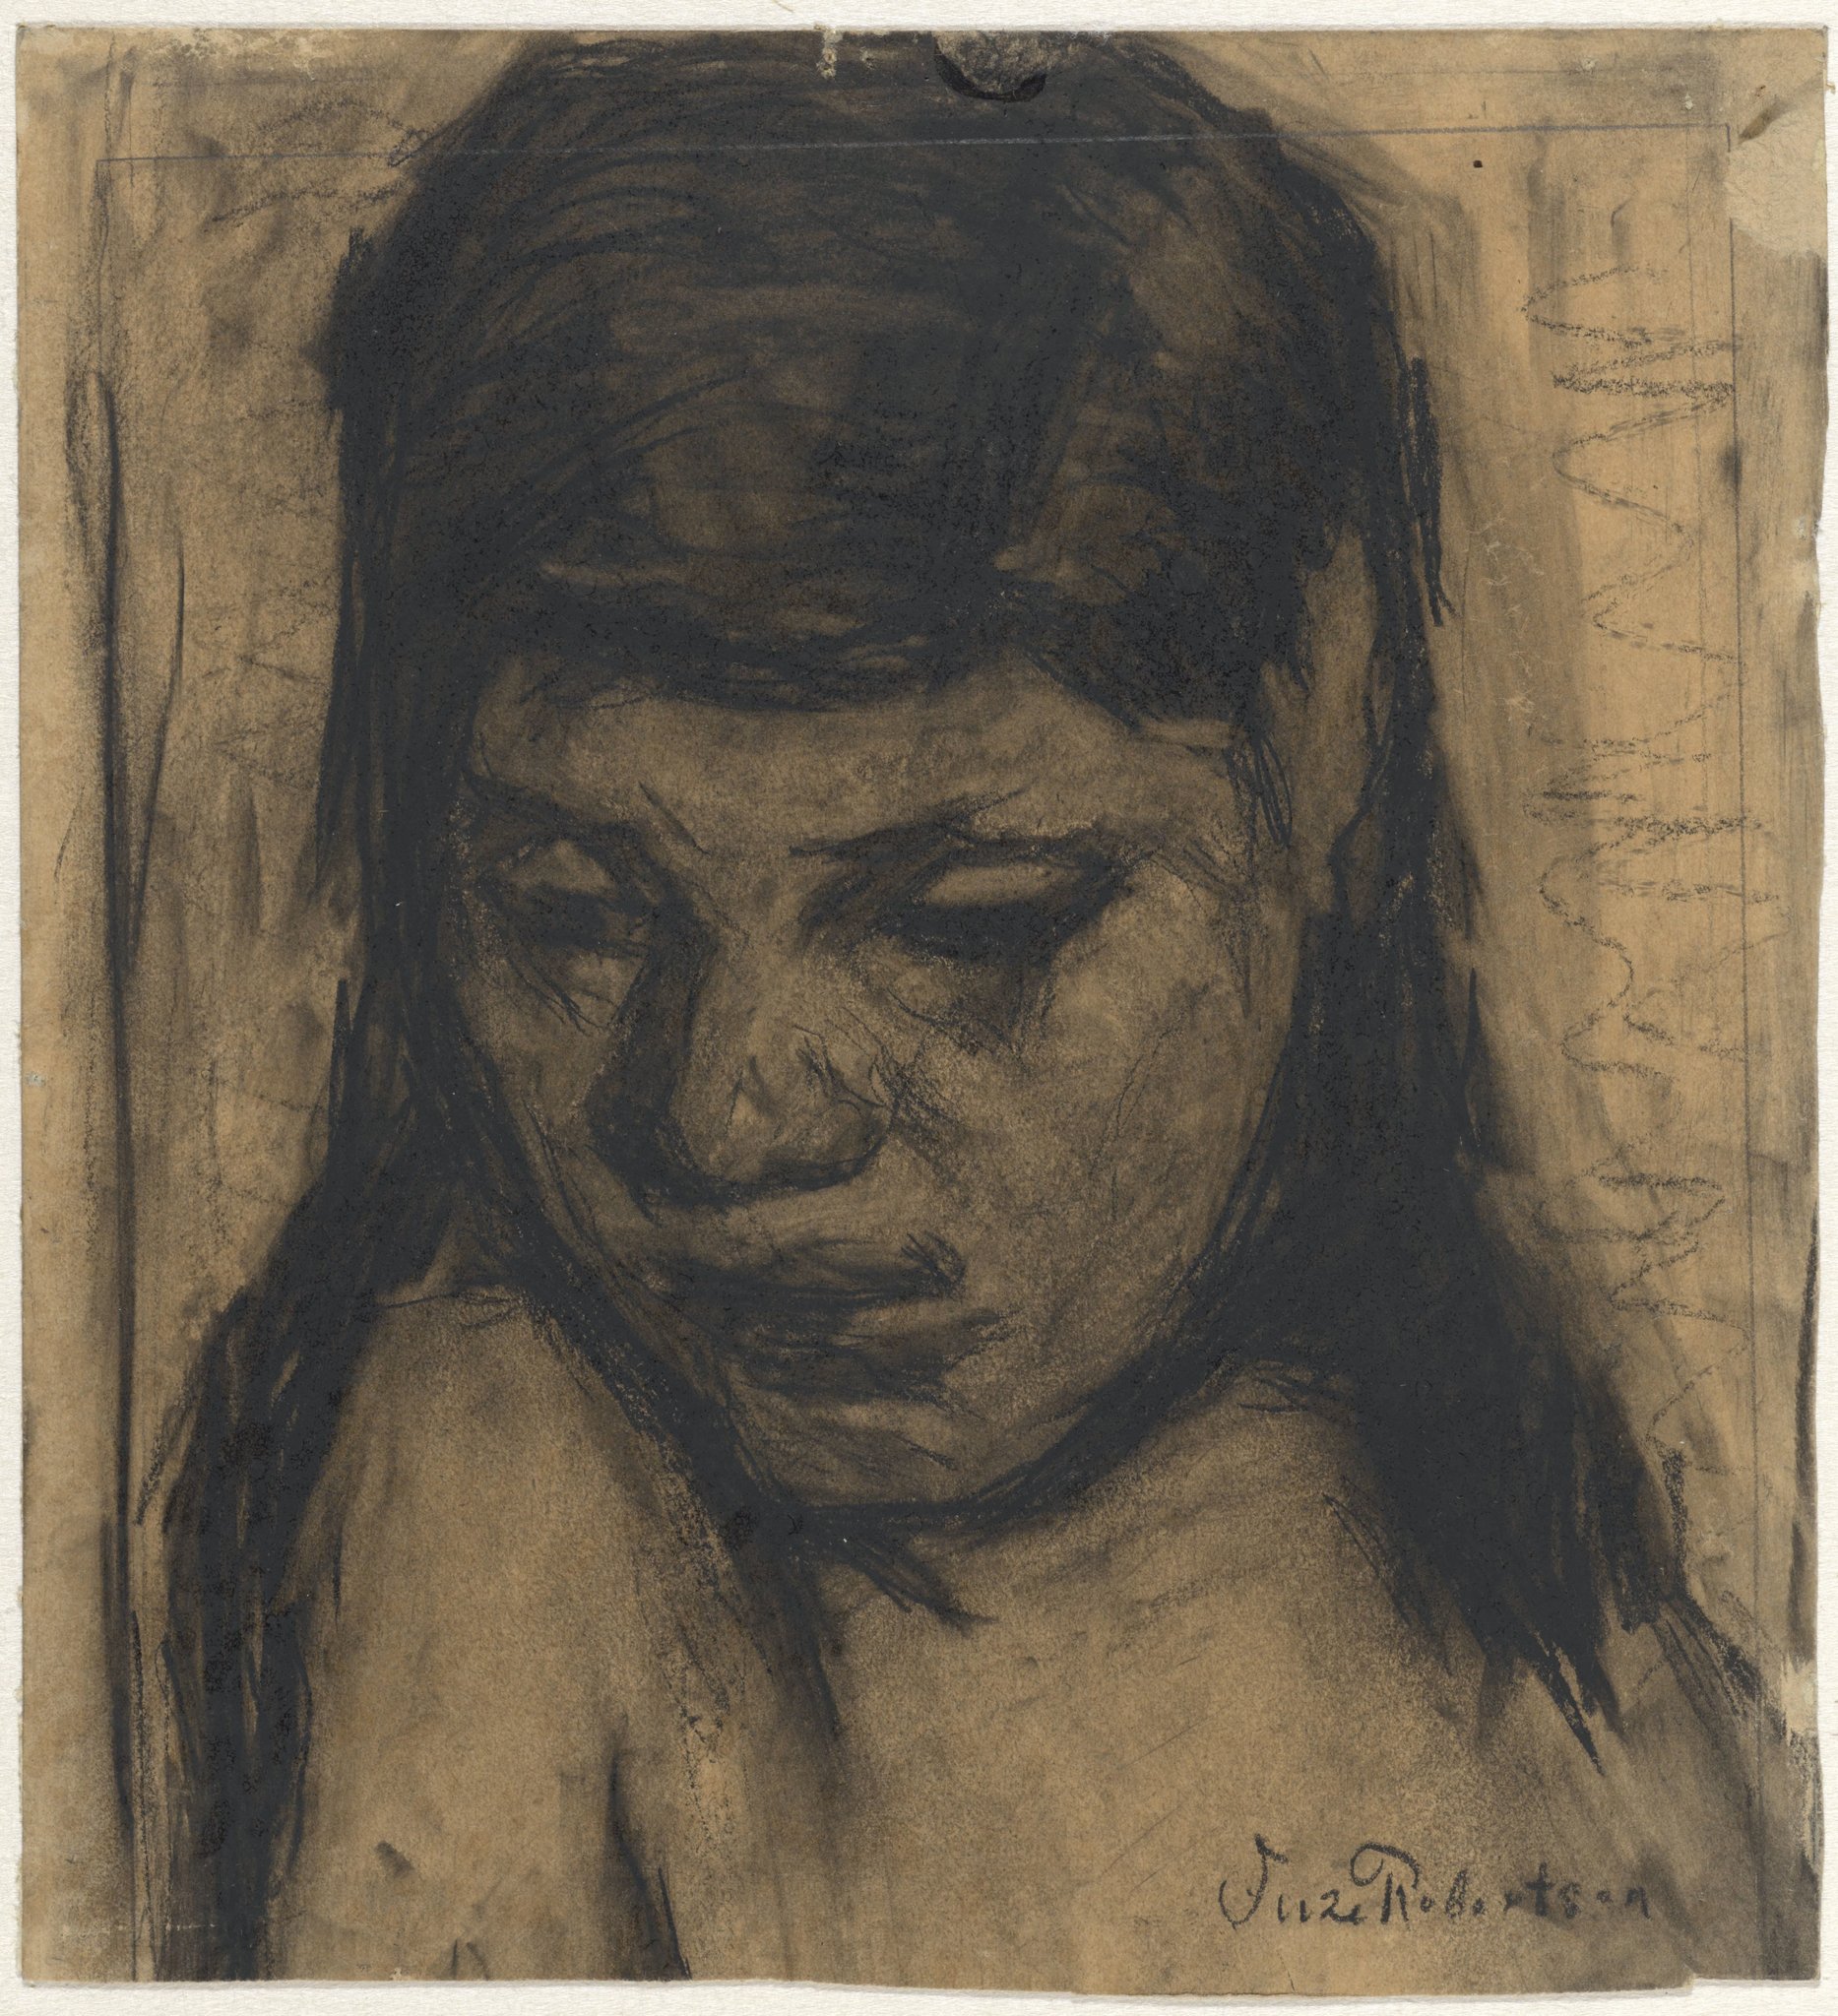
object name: drawing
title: Hoofd van een meisje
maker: suze robertson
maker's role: draughtsman, painter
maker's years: 1855-1922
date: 1901-1902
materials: chalk, paper